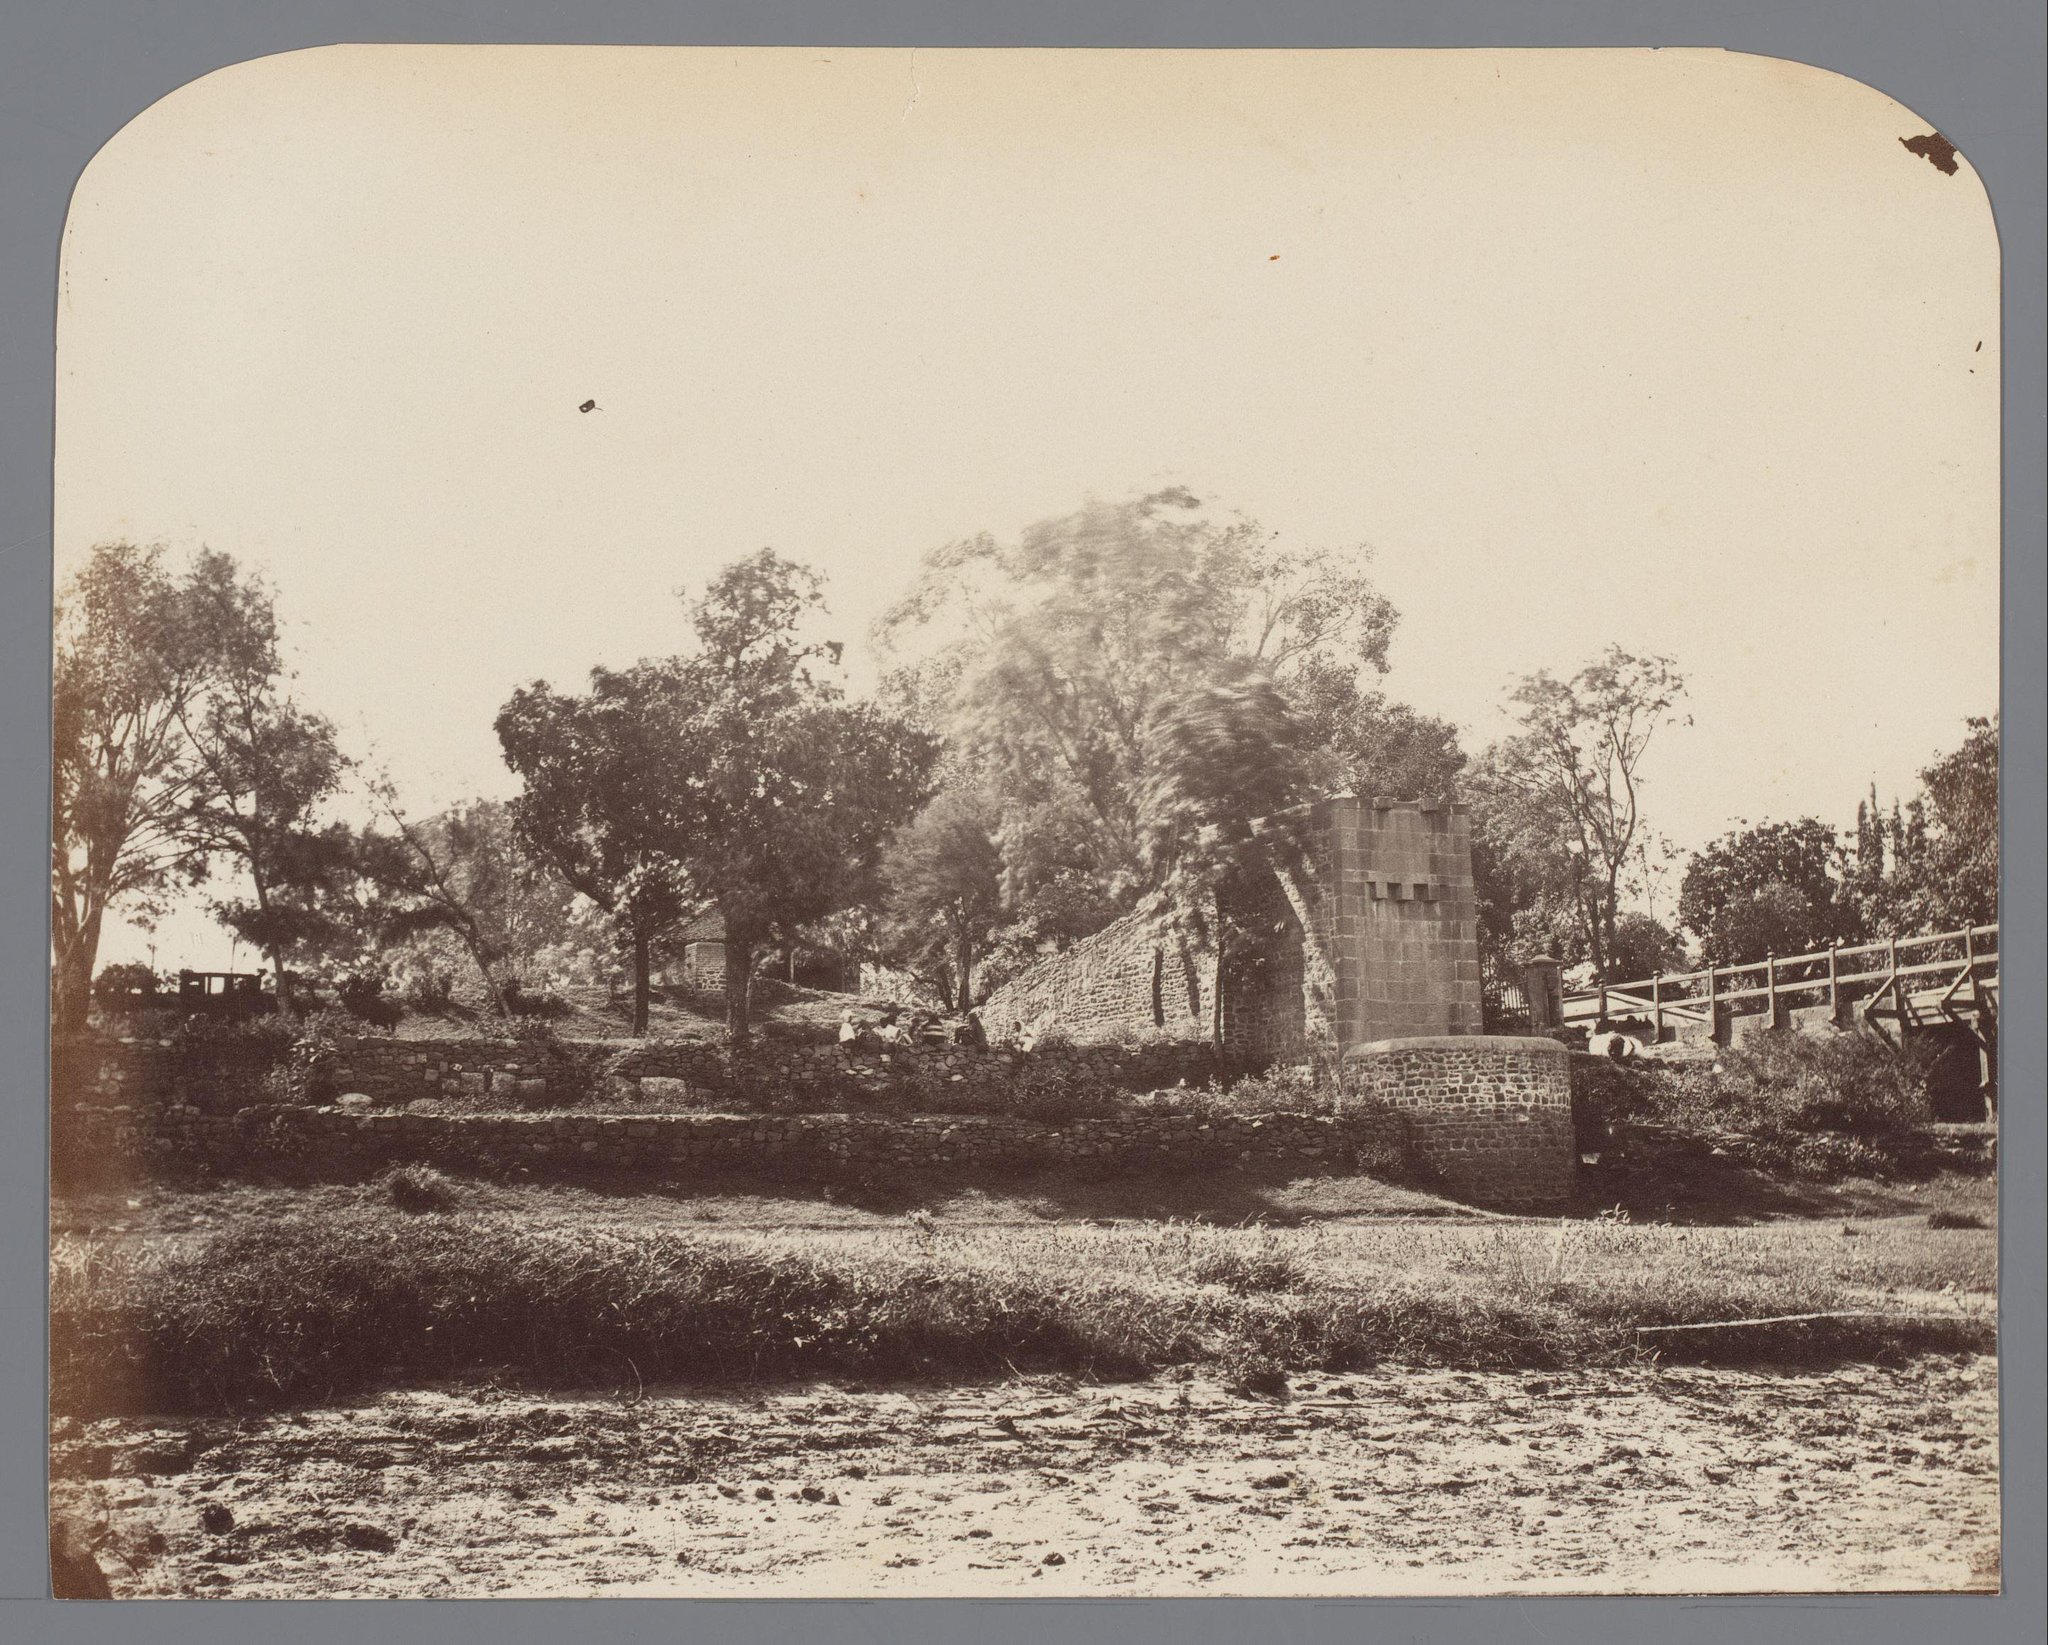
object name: photograph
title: Ruïnes van kerk, kasteel, of stadsmuur (?)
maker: Anonymous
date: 1865-1885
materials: photographic support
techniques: albumen print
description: Ruïne van muren van een kerk, kasteel, of stadsmuur (?) in vlak zonlicht.